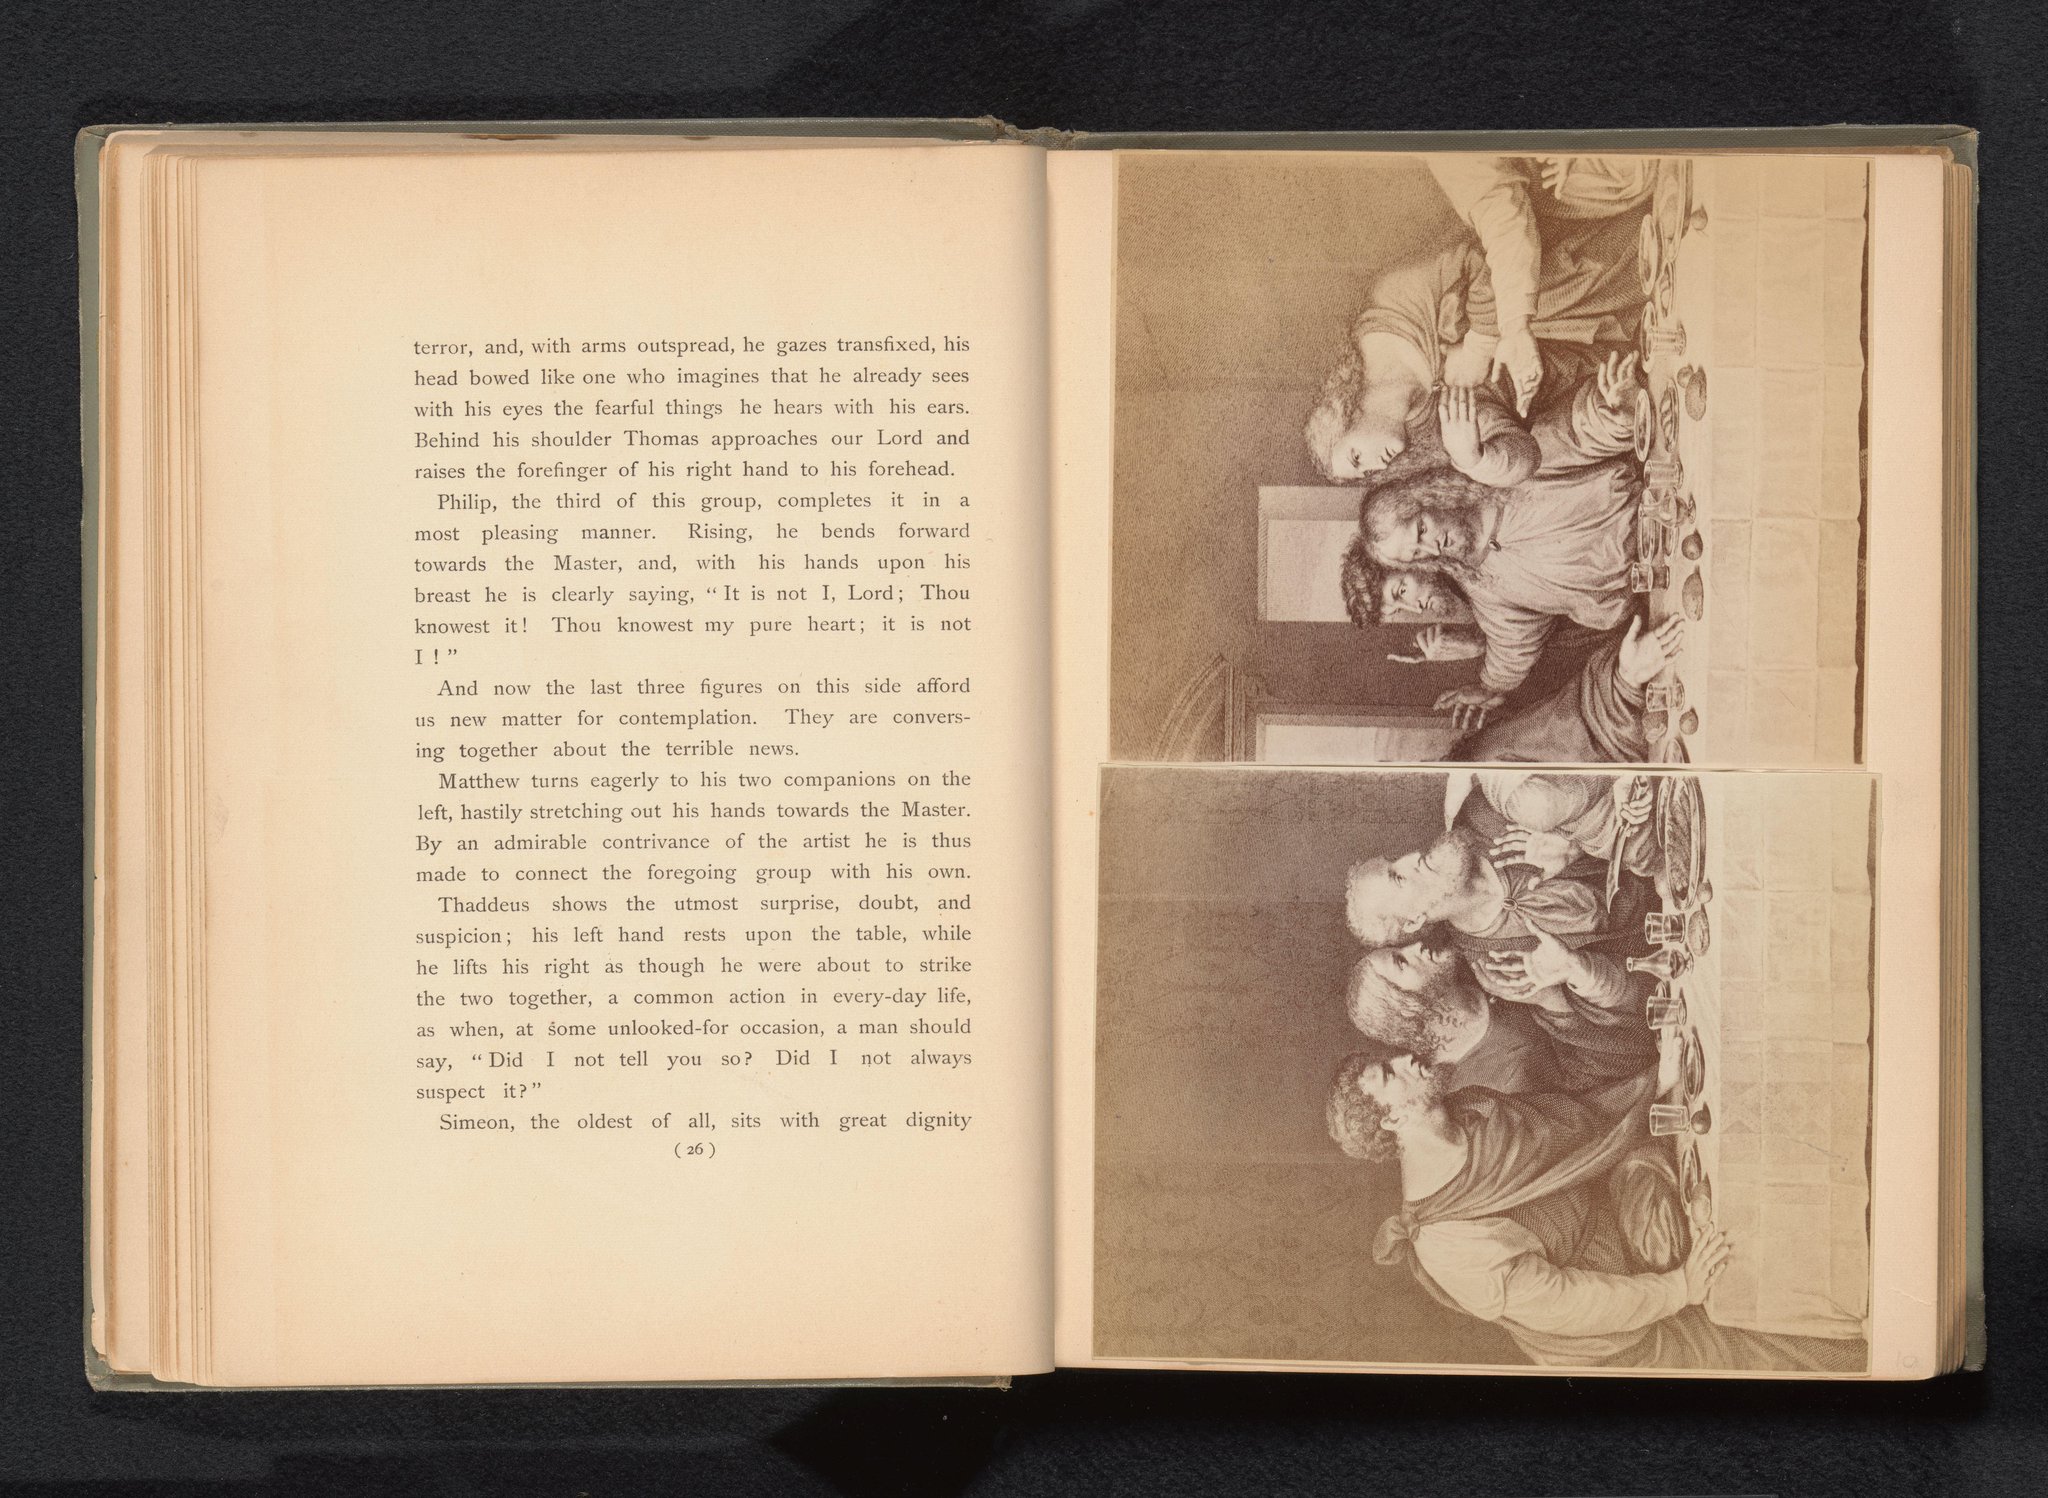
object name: photograph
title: Twee fotoreproducties van een prent naar een muurschildering, voorstellende het Laatste Avondmaal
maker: Anonymous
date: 1882-1887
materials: photographic support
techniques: albumen print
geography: s. maria delle grazie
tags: the episode of the last supper